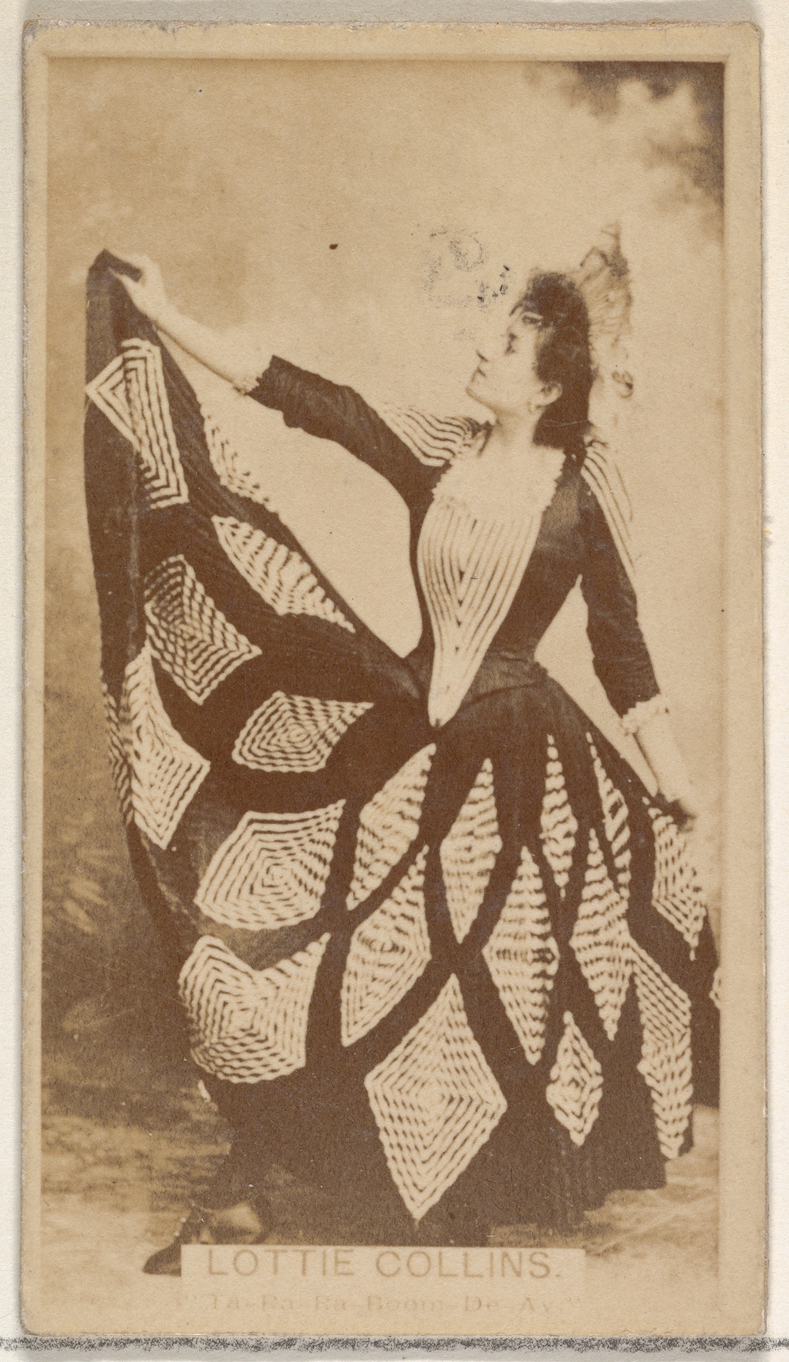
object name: photograph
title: Lottie Collins, from the Actors and Actresses series (N45, Type 8) for Virginia Brights Cigarettes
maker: allen & ginter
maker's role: publisher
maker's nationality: american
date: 1888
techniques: albumen silver print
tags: portraits,women,actresses